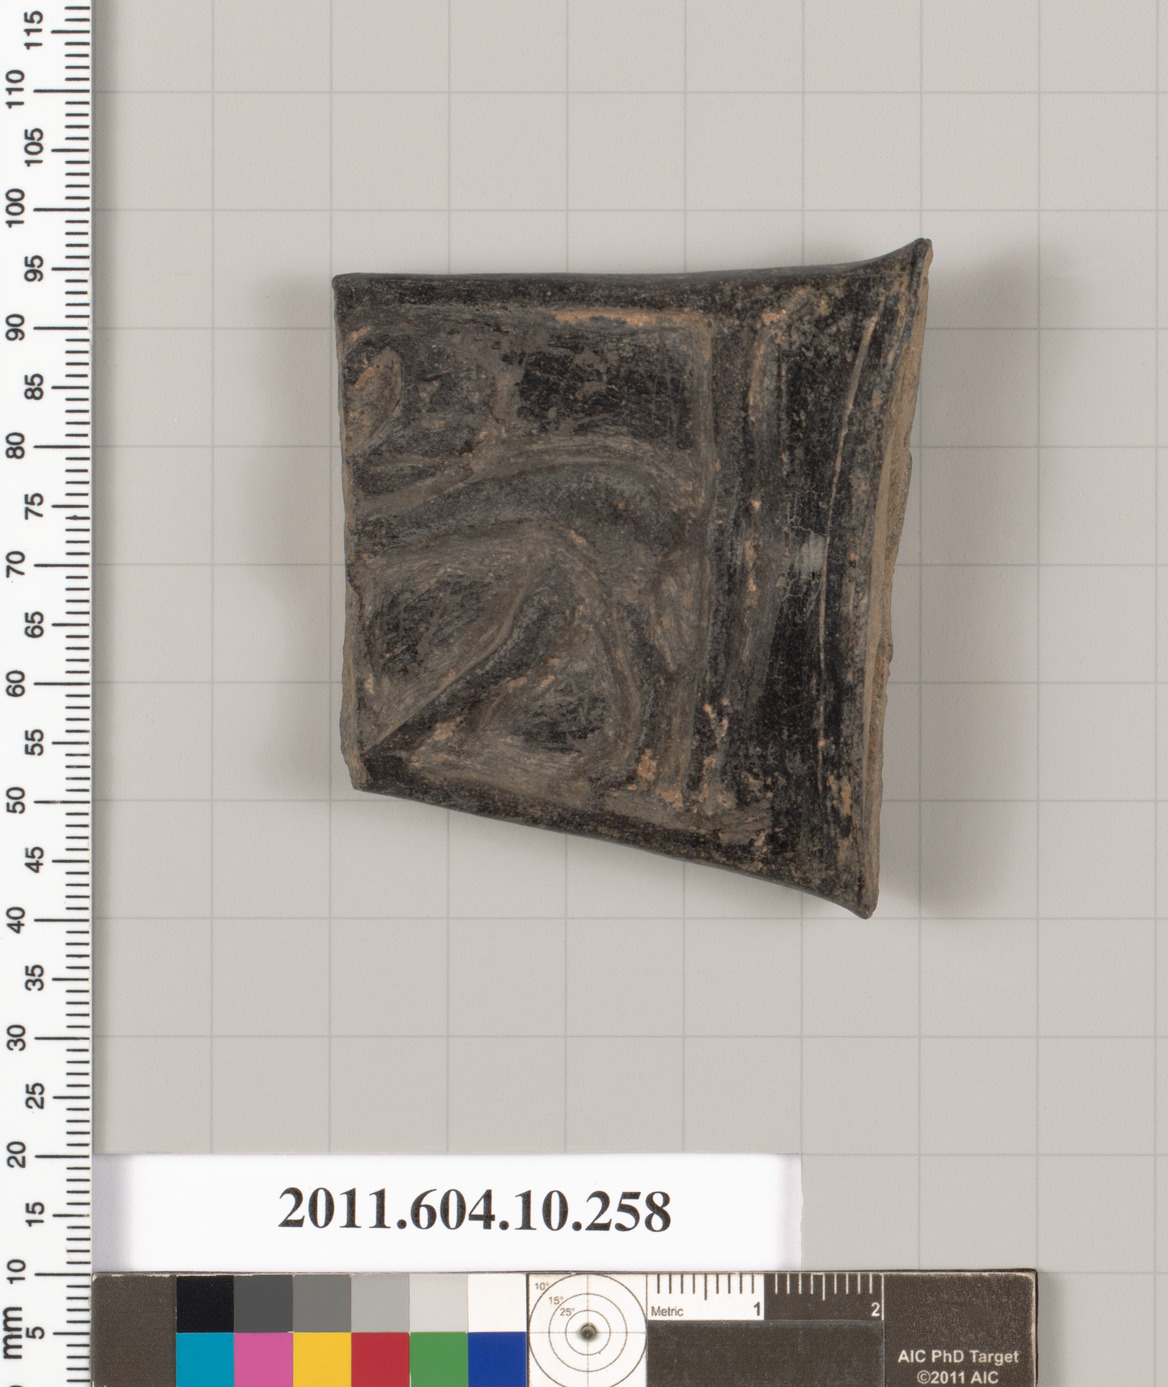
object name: nicosthenic neck amphora fragment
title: Terracotta fragment of a Nicosthenic neck-amphora (jar)?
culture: etruscan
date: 625-601 BCE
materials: terracotta